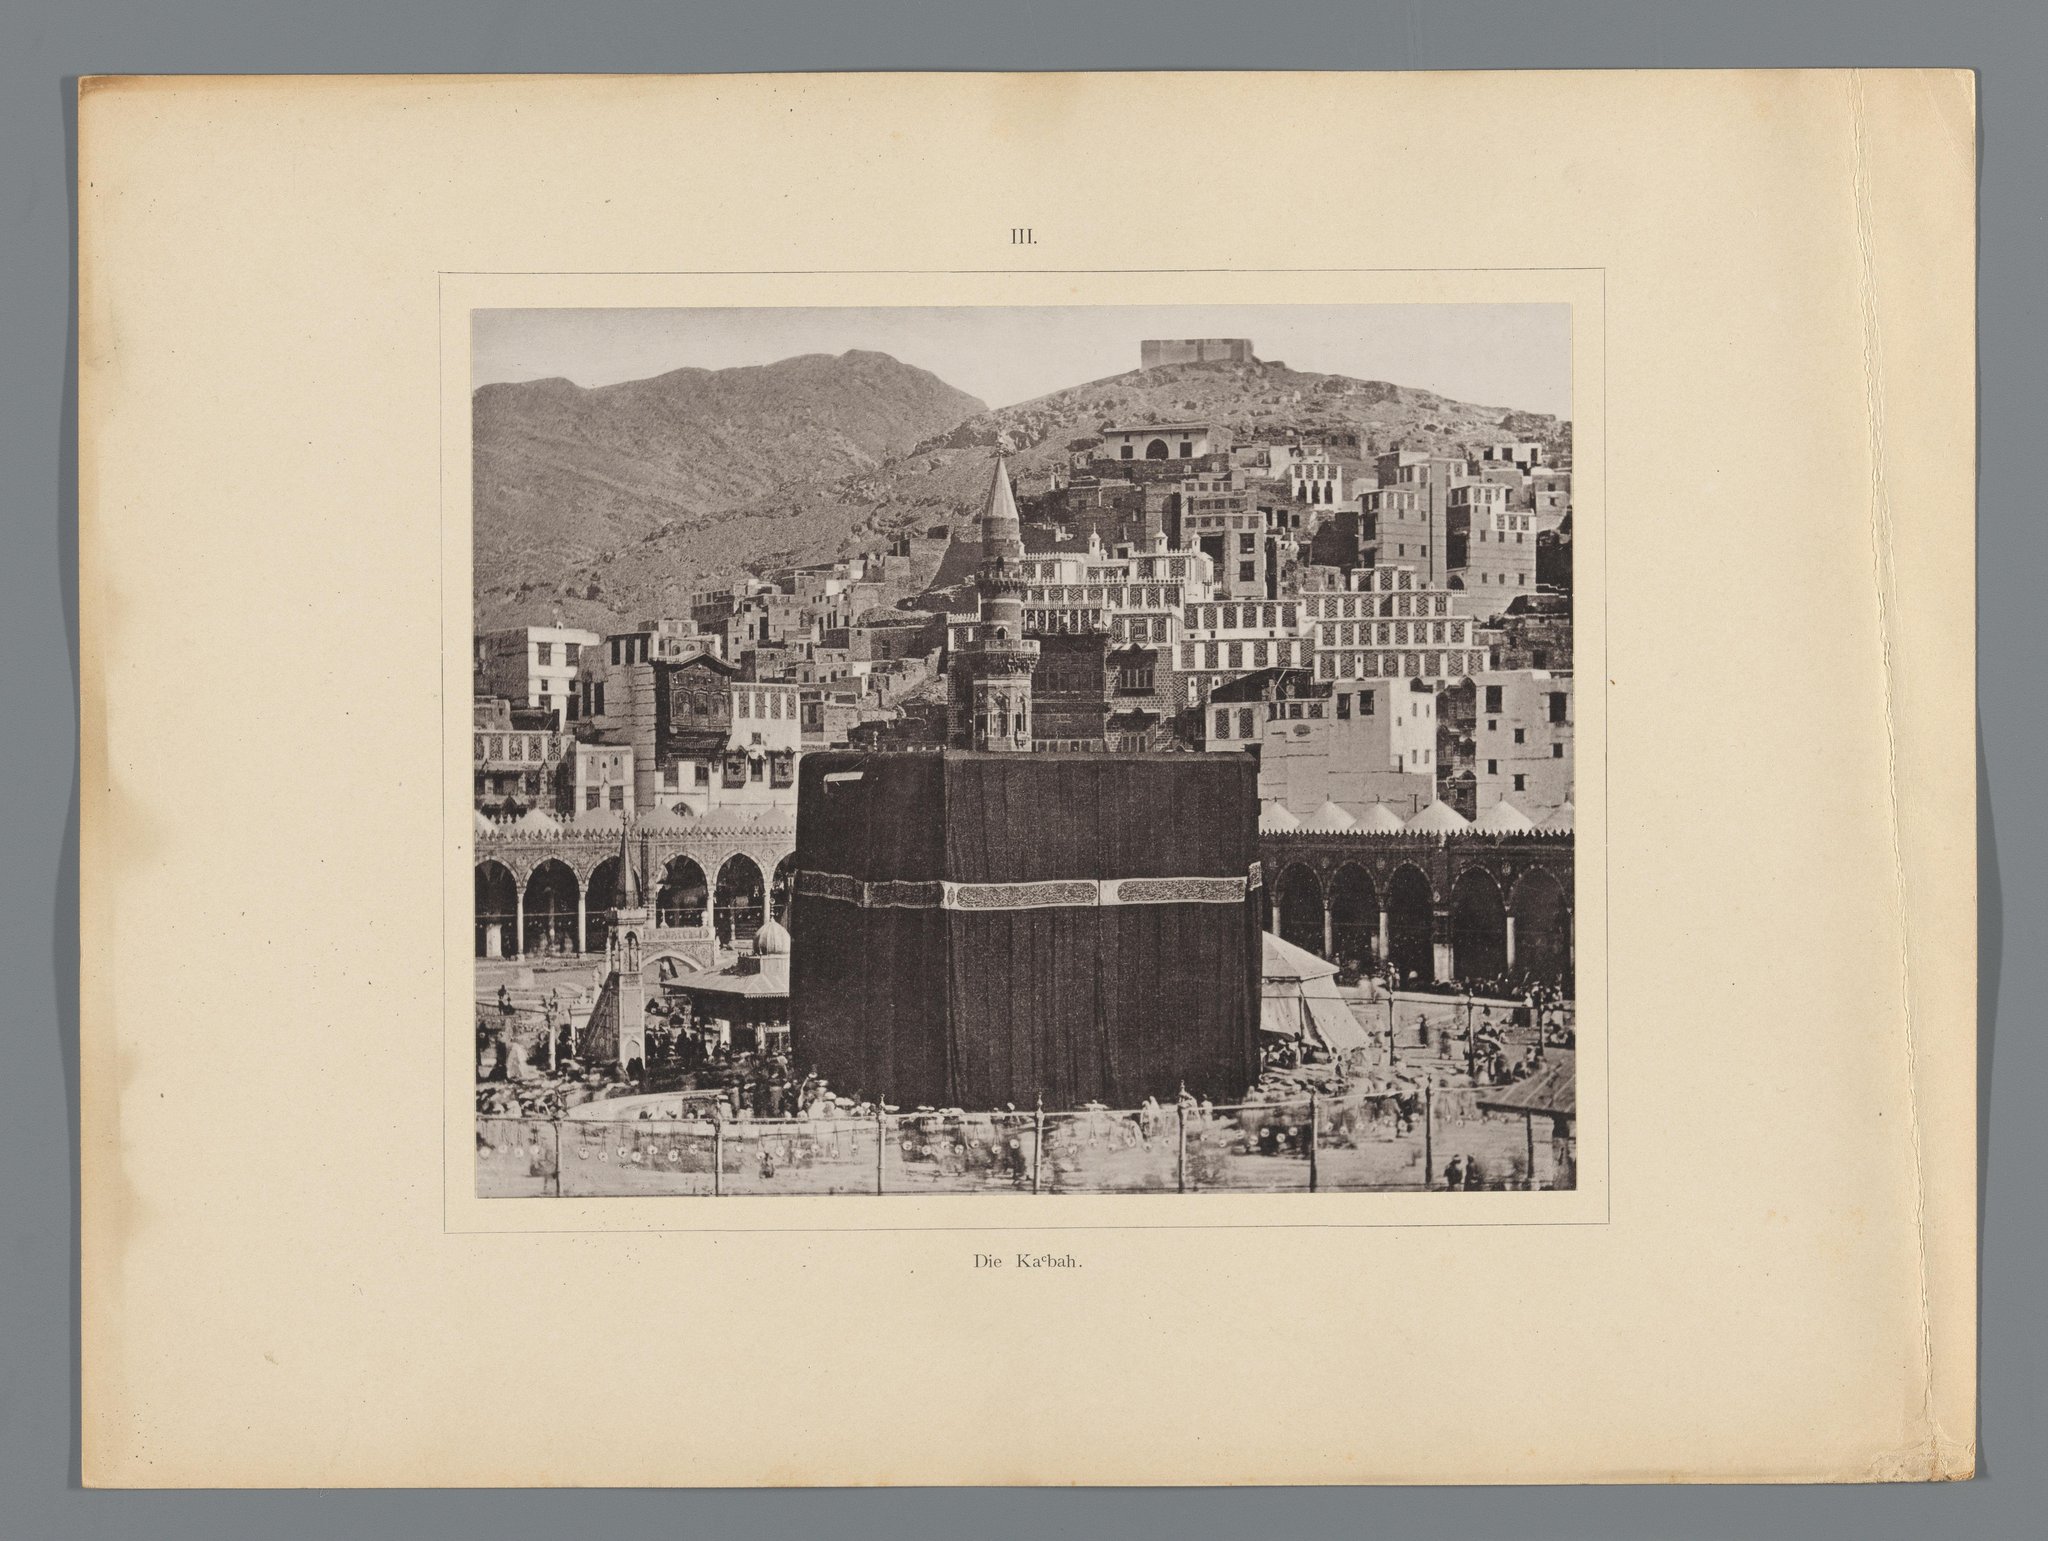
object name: photomechanical print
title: Gezicht op de Ka'aba te Mekka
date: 1883-1888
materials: paper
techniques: photograph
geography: mecca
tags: temple, shrine ~ islam, mohammedanism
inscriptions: number: ‘III.’